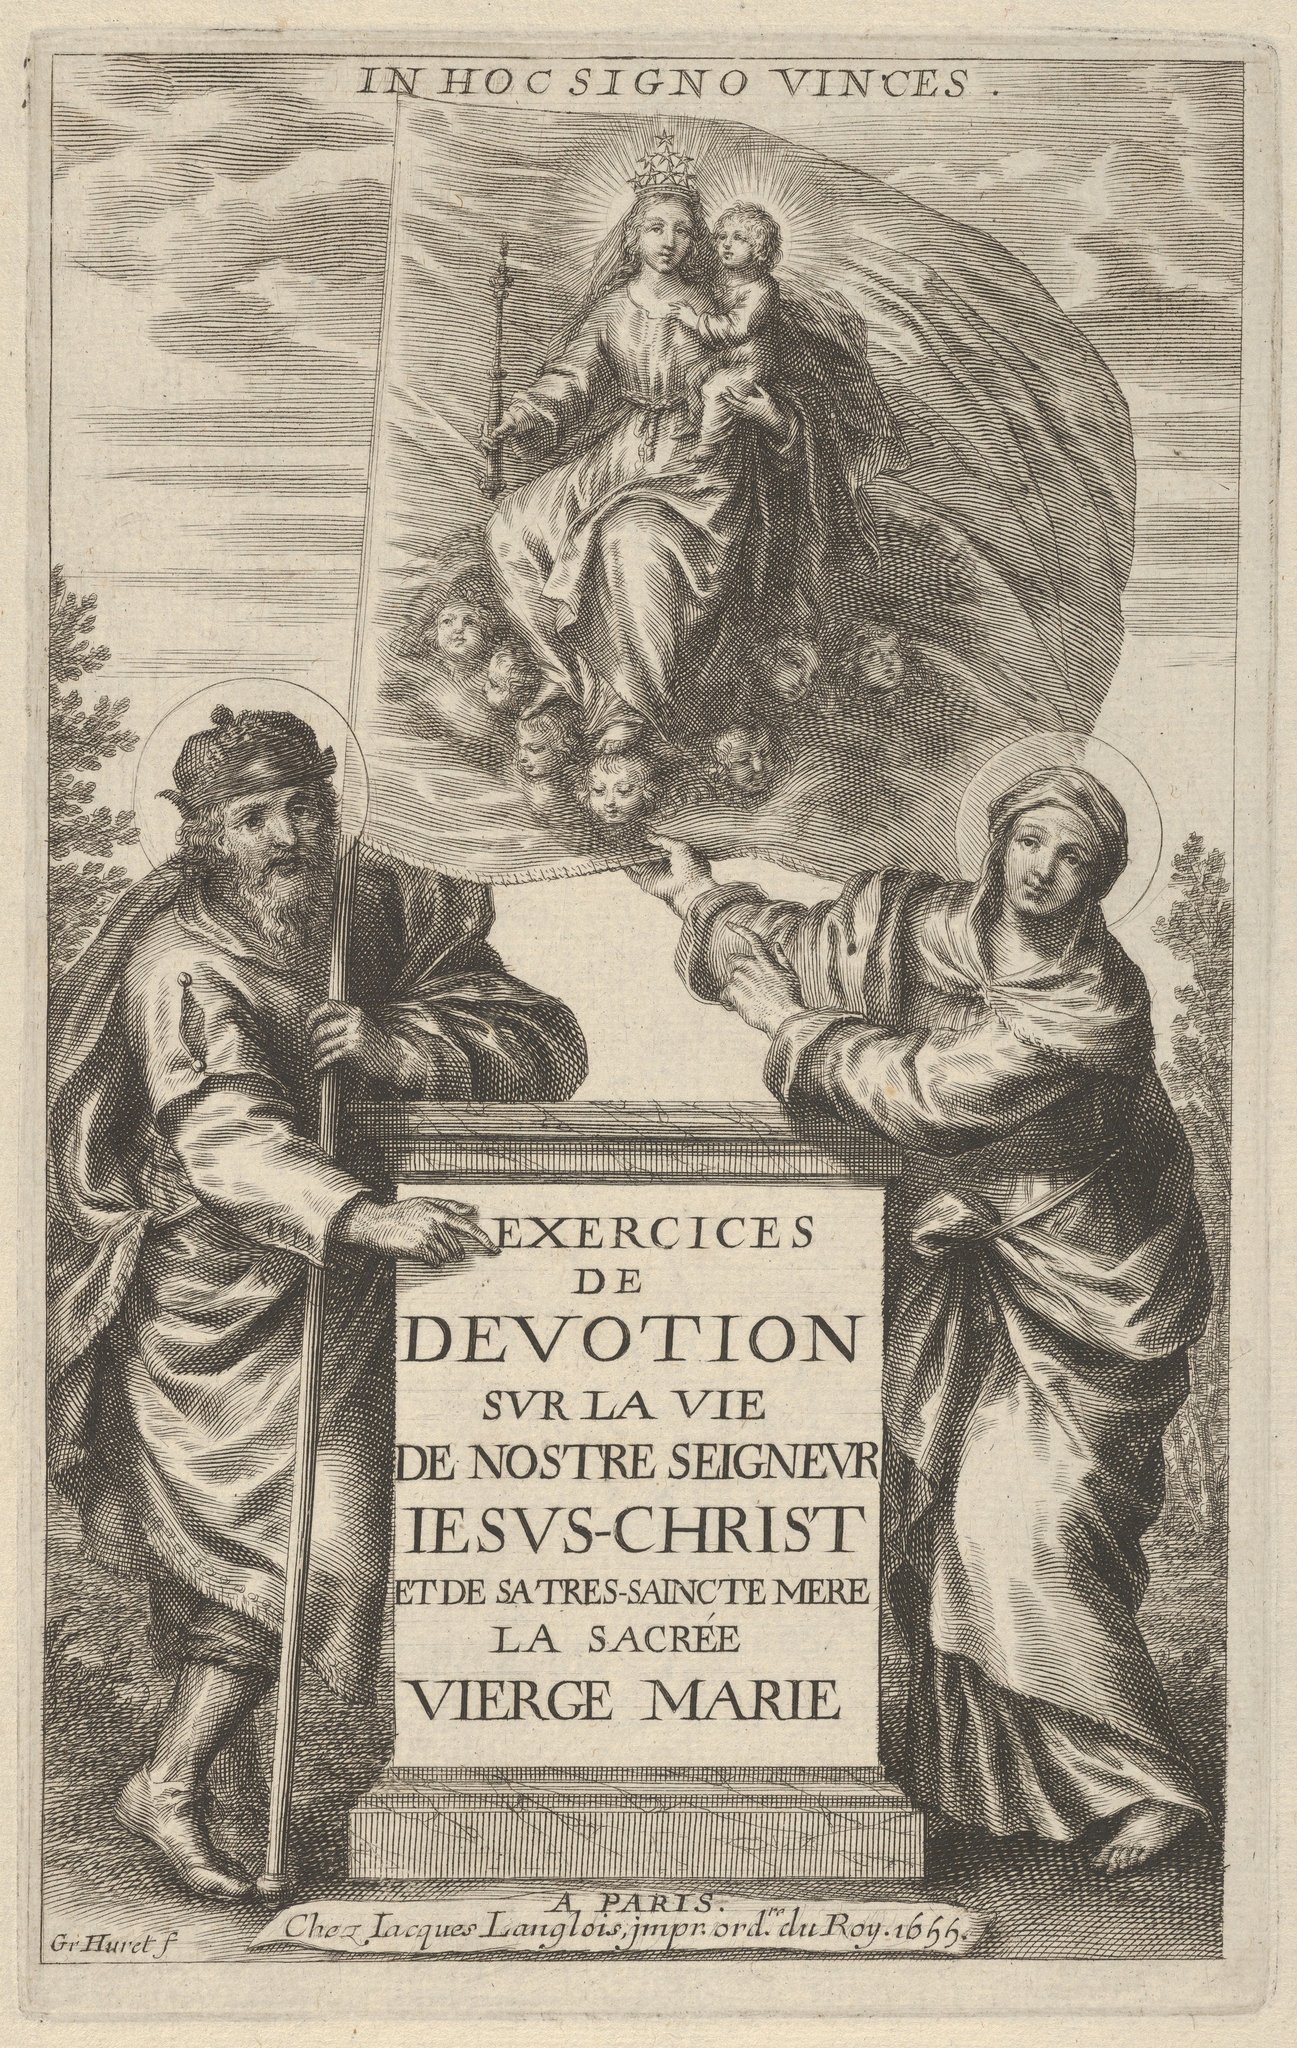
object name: print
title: Frontispiece for Exercises de Devotion sur la Vie de Nostre Seigneur Iesus-Christ [...]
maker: grégoire huret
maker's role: artist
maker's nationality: french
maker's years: 1606-1670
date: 1655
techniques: engraving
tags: men,women,virgin mary,jesus